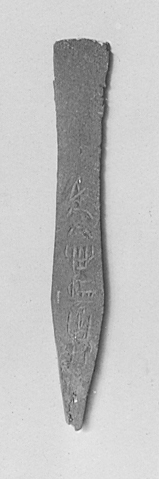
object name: chisel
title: Inscribed Chisel From Foundation Deposit 2 of Hatshepsut's Valley Temple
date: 1479-1458 BCE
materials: bronze, copper alloy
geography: egypt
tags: hieroglyphs